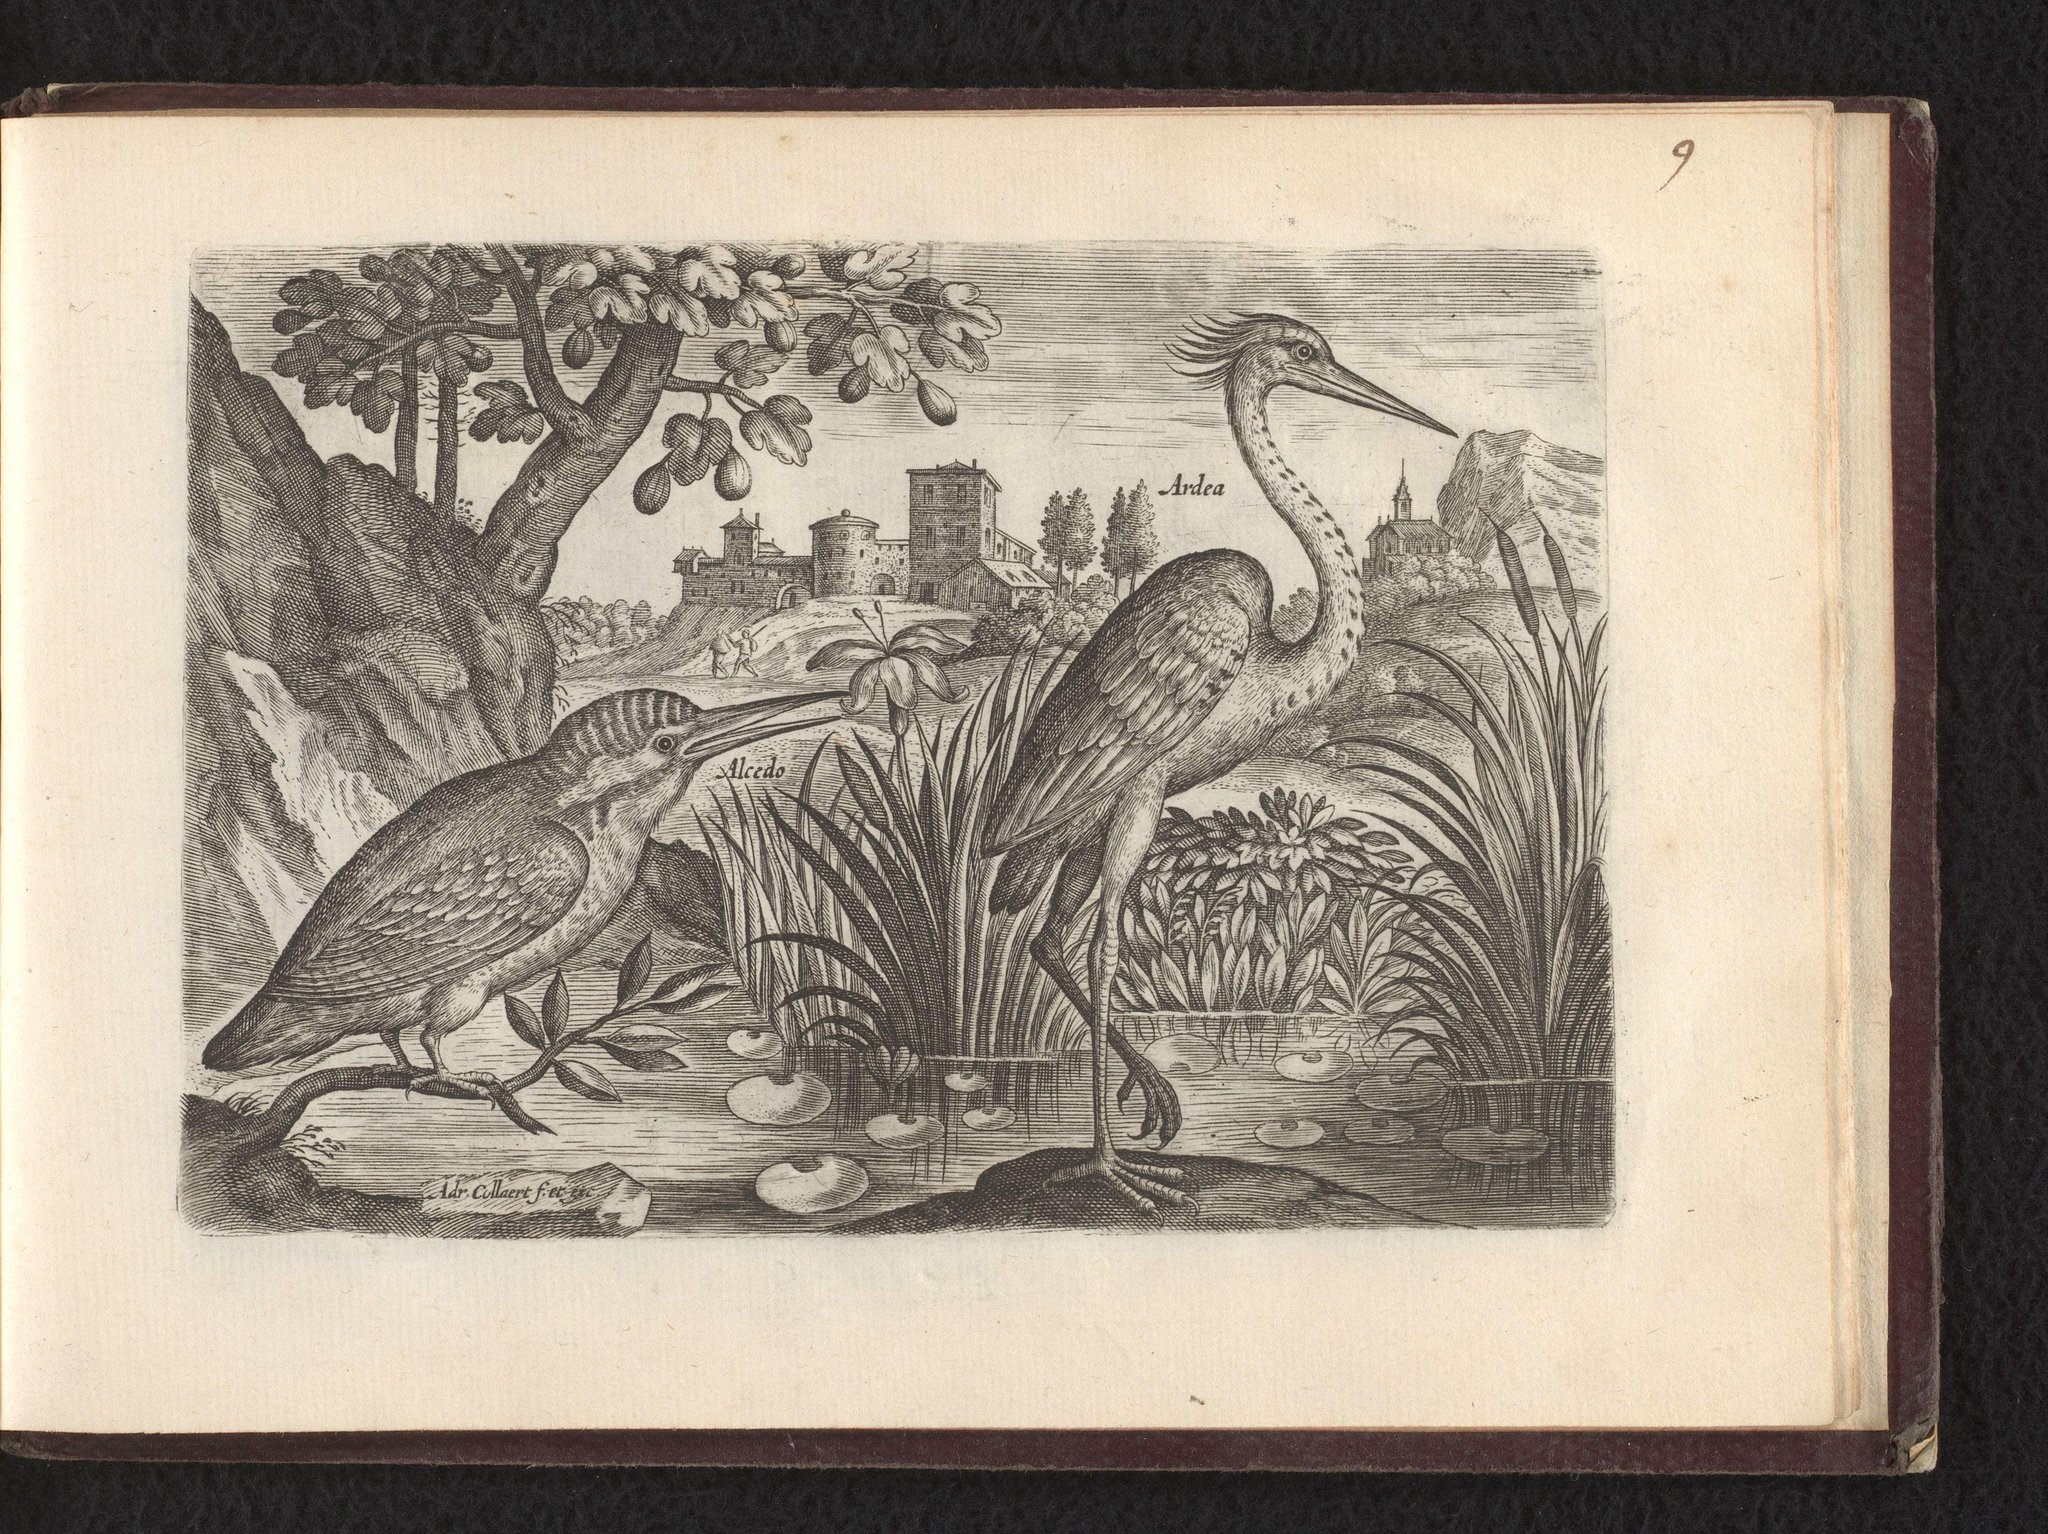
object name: print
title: Alcedo (ijsvogel) en Ardea (blauwe reiger)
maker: adriaen collaert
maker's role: draughtsman, print maker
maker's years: 1560-1618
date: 1600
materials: paper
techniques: engraving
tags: shore-birds and wading-birds: heron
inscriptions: signature and address: ‘Adrian Collaert f. et exc.’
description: Alcedo (ijsvogel) en Ardea (blauwe reiger, voor een rivierlandschap.